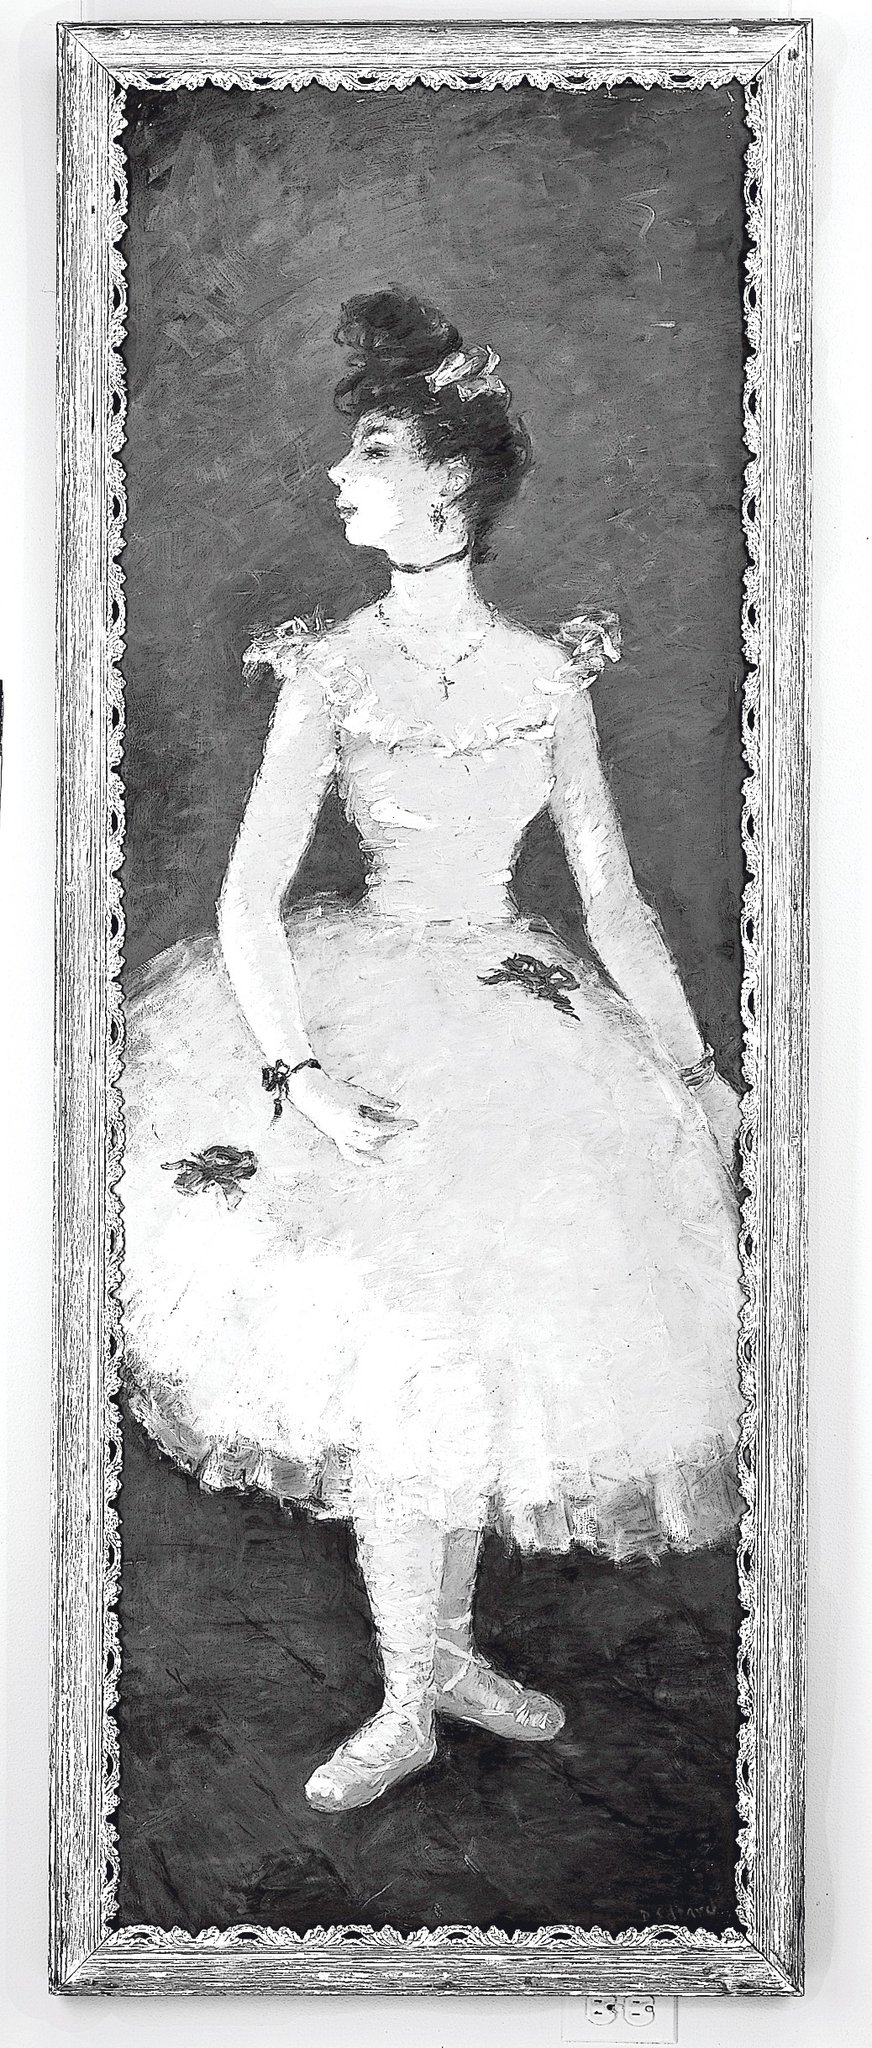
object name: frame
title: Baguette molding (pair with 1975.1.2508)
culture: french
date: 1740-1750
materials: wood